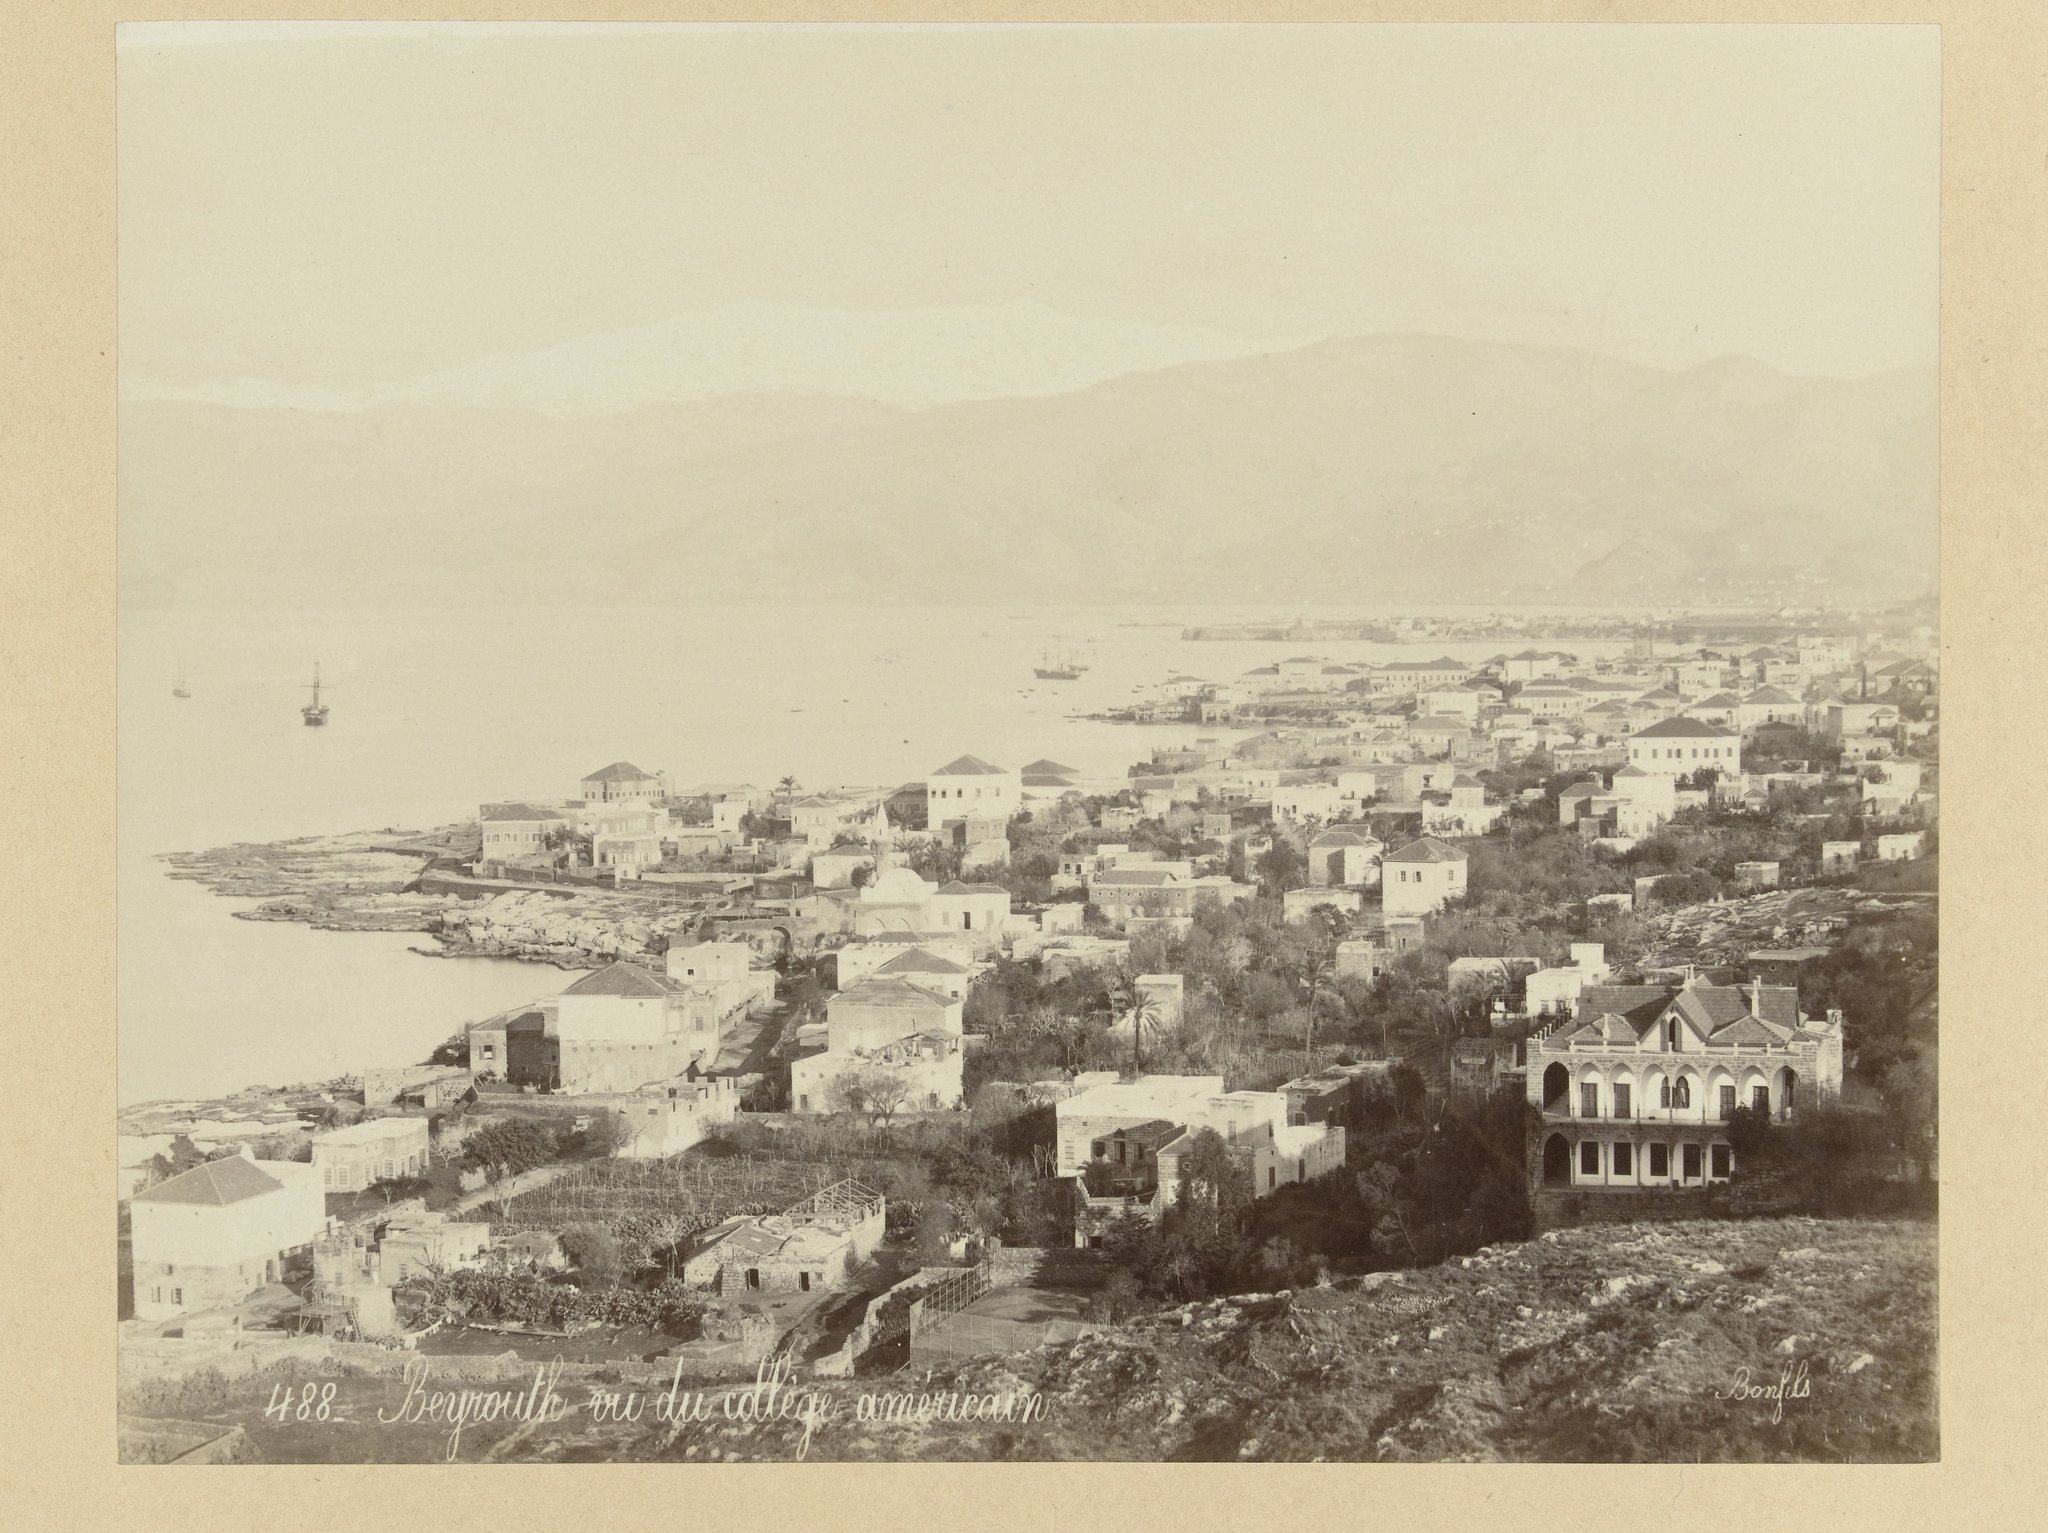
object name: photograph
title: Beyrouth vu du collège américain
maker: félix bonfils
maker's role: fotograaf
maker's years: 1831-1885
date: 1867-1877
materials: cardboard, paper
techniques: albumen print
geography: ottoman empire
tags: city-view in general; 'veduta'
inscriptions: check stamp: ‘Bristol/ L.M.’, stamp: ‘Gemeentelijke bibliotheek/ Rotterdam’, title: ‘S 65. Beyrouth. Syrië.’, number: ‘488’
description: Onderdeel van een groep door fotograaf Richard Polak op reis verzamelde foto’s. Deze foto is samen met andere op zijn reizen verzamelde foto's tentoongesteld bij de Rotterdamsche Kunstkring (1895), Arti en Amicitiae te Amsterdam (1897-1898?) en Societeit 't Collegie te Kampen (datum vooralsnog onbekend).